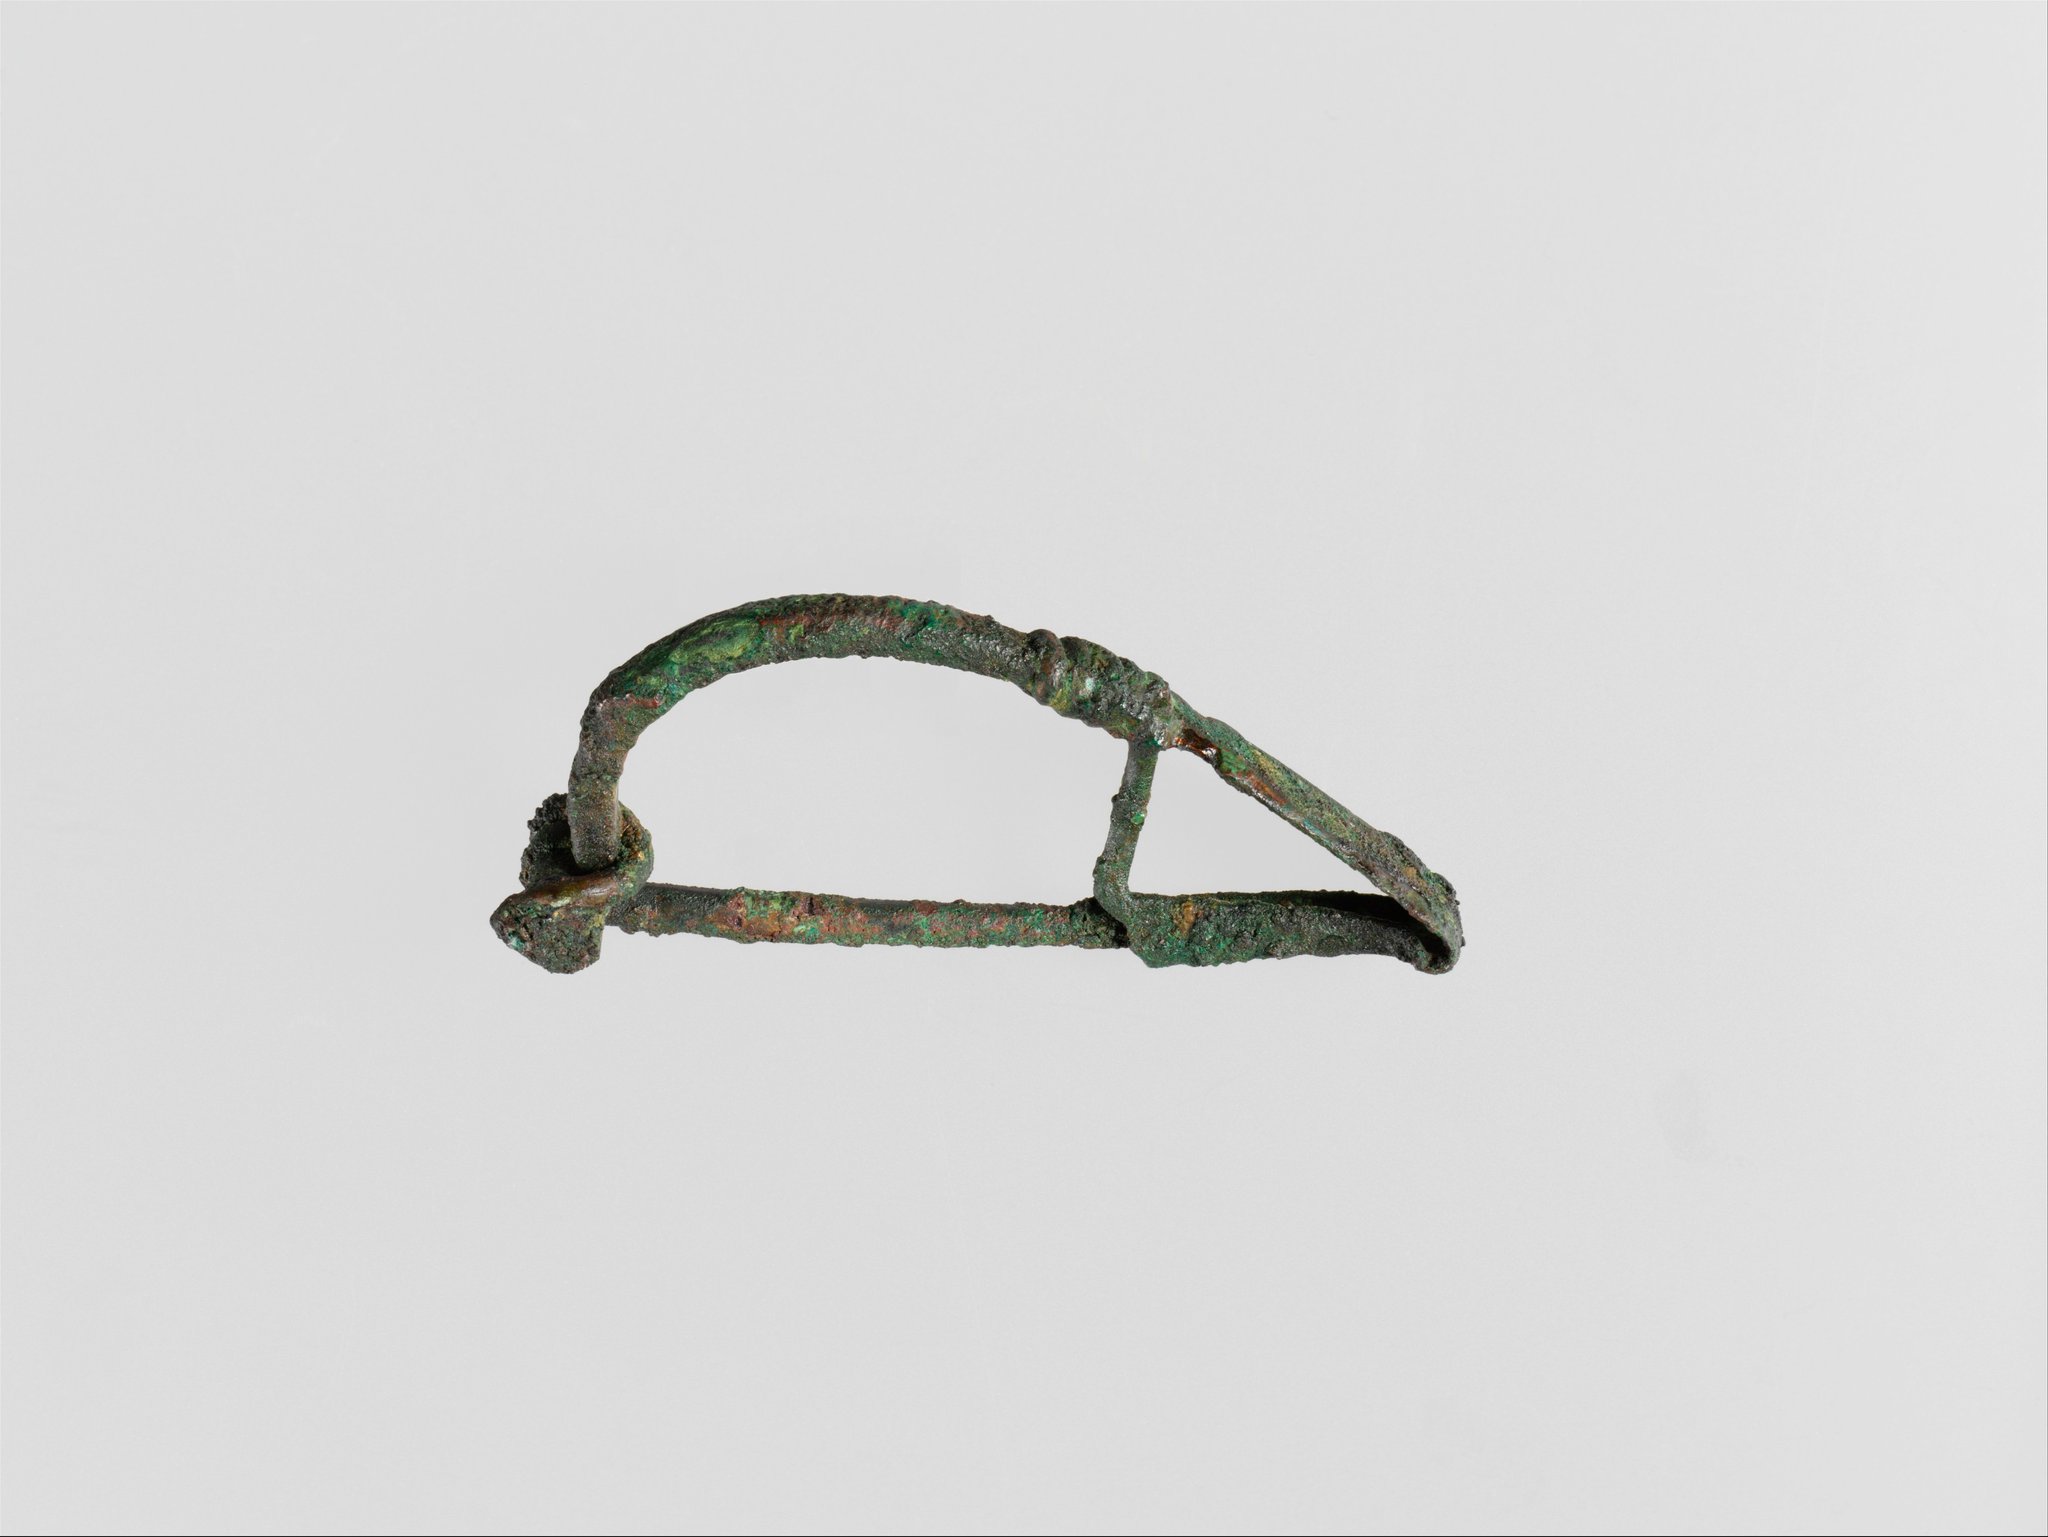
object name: fibula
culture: etruscan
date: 700-601 BCE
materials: bronze